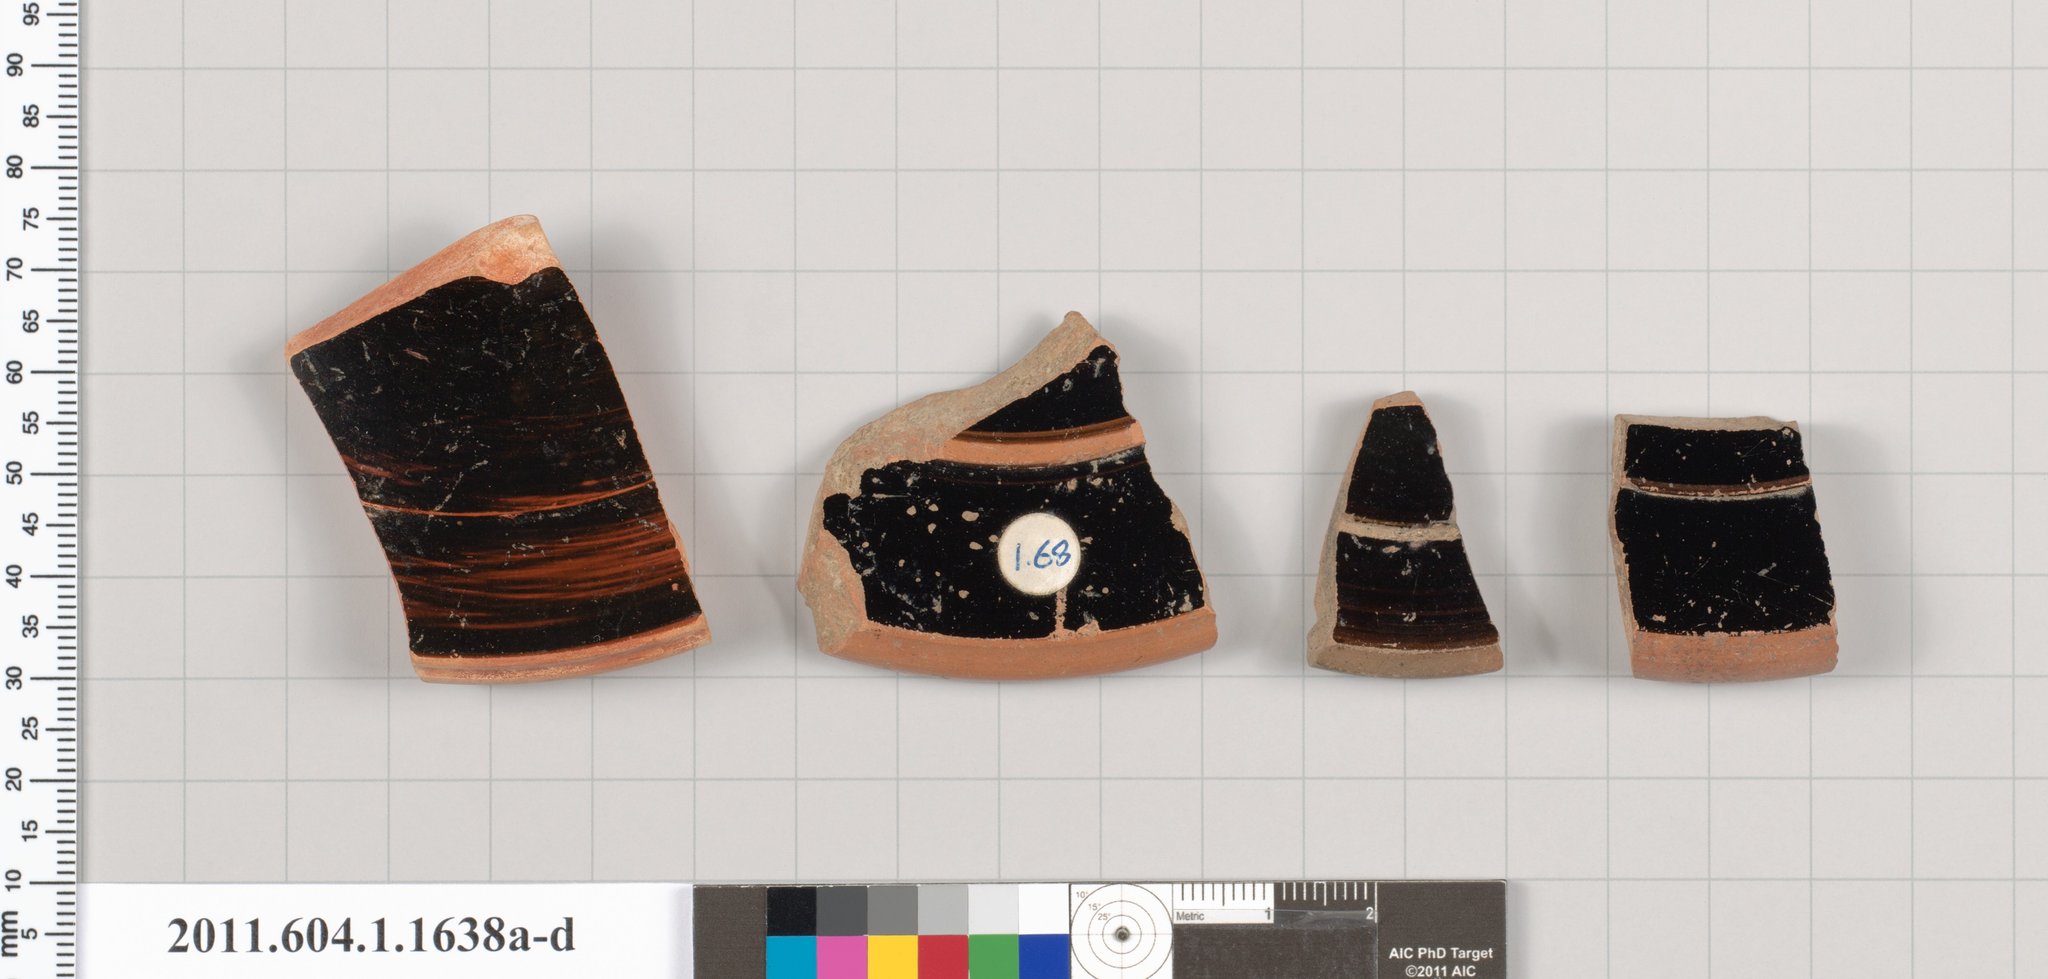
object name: kylix fragment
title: Terracotta fragments of kylikes (drinking cups)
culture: greek, attic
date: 500-401 BCE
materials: terracotta